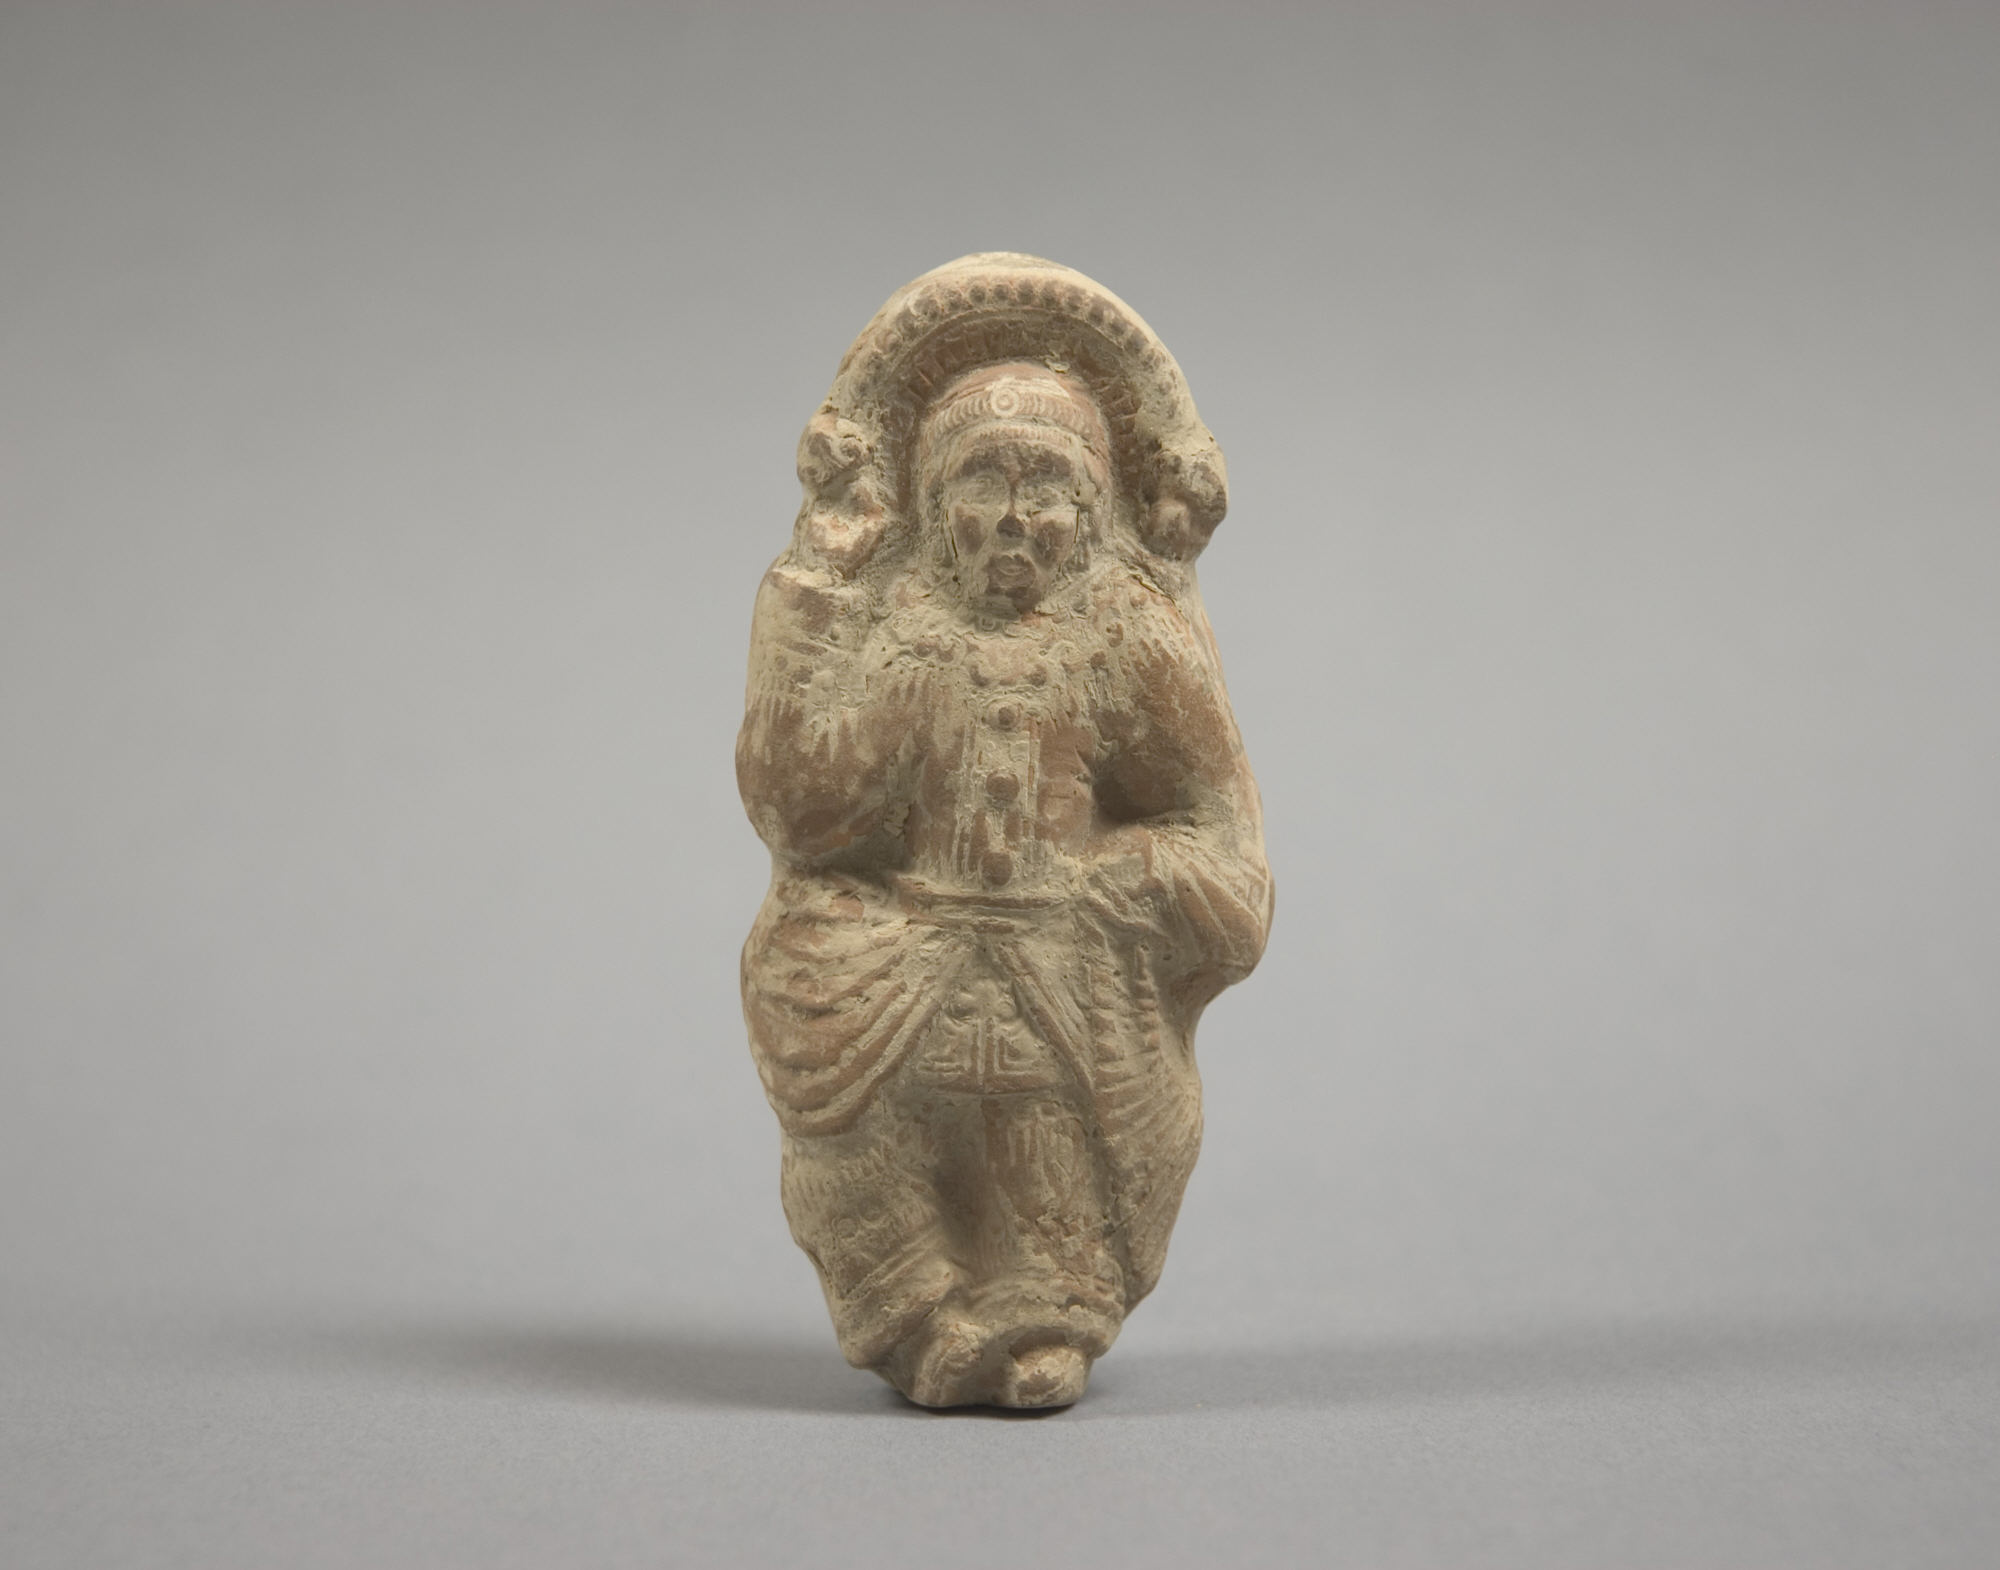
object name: figure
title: Figure of an actor(?)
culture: chinese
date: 960-1279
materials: pottery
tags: actors